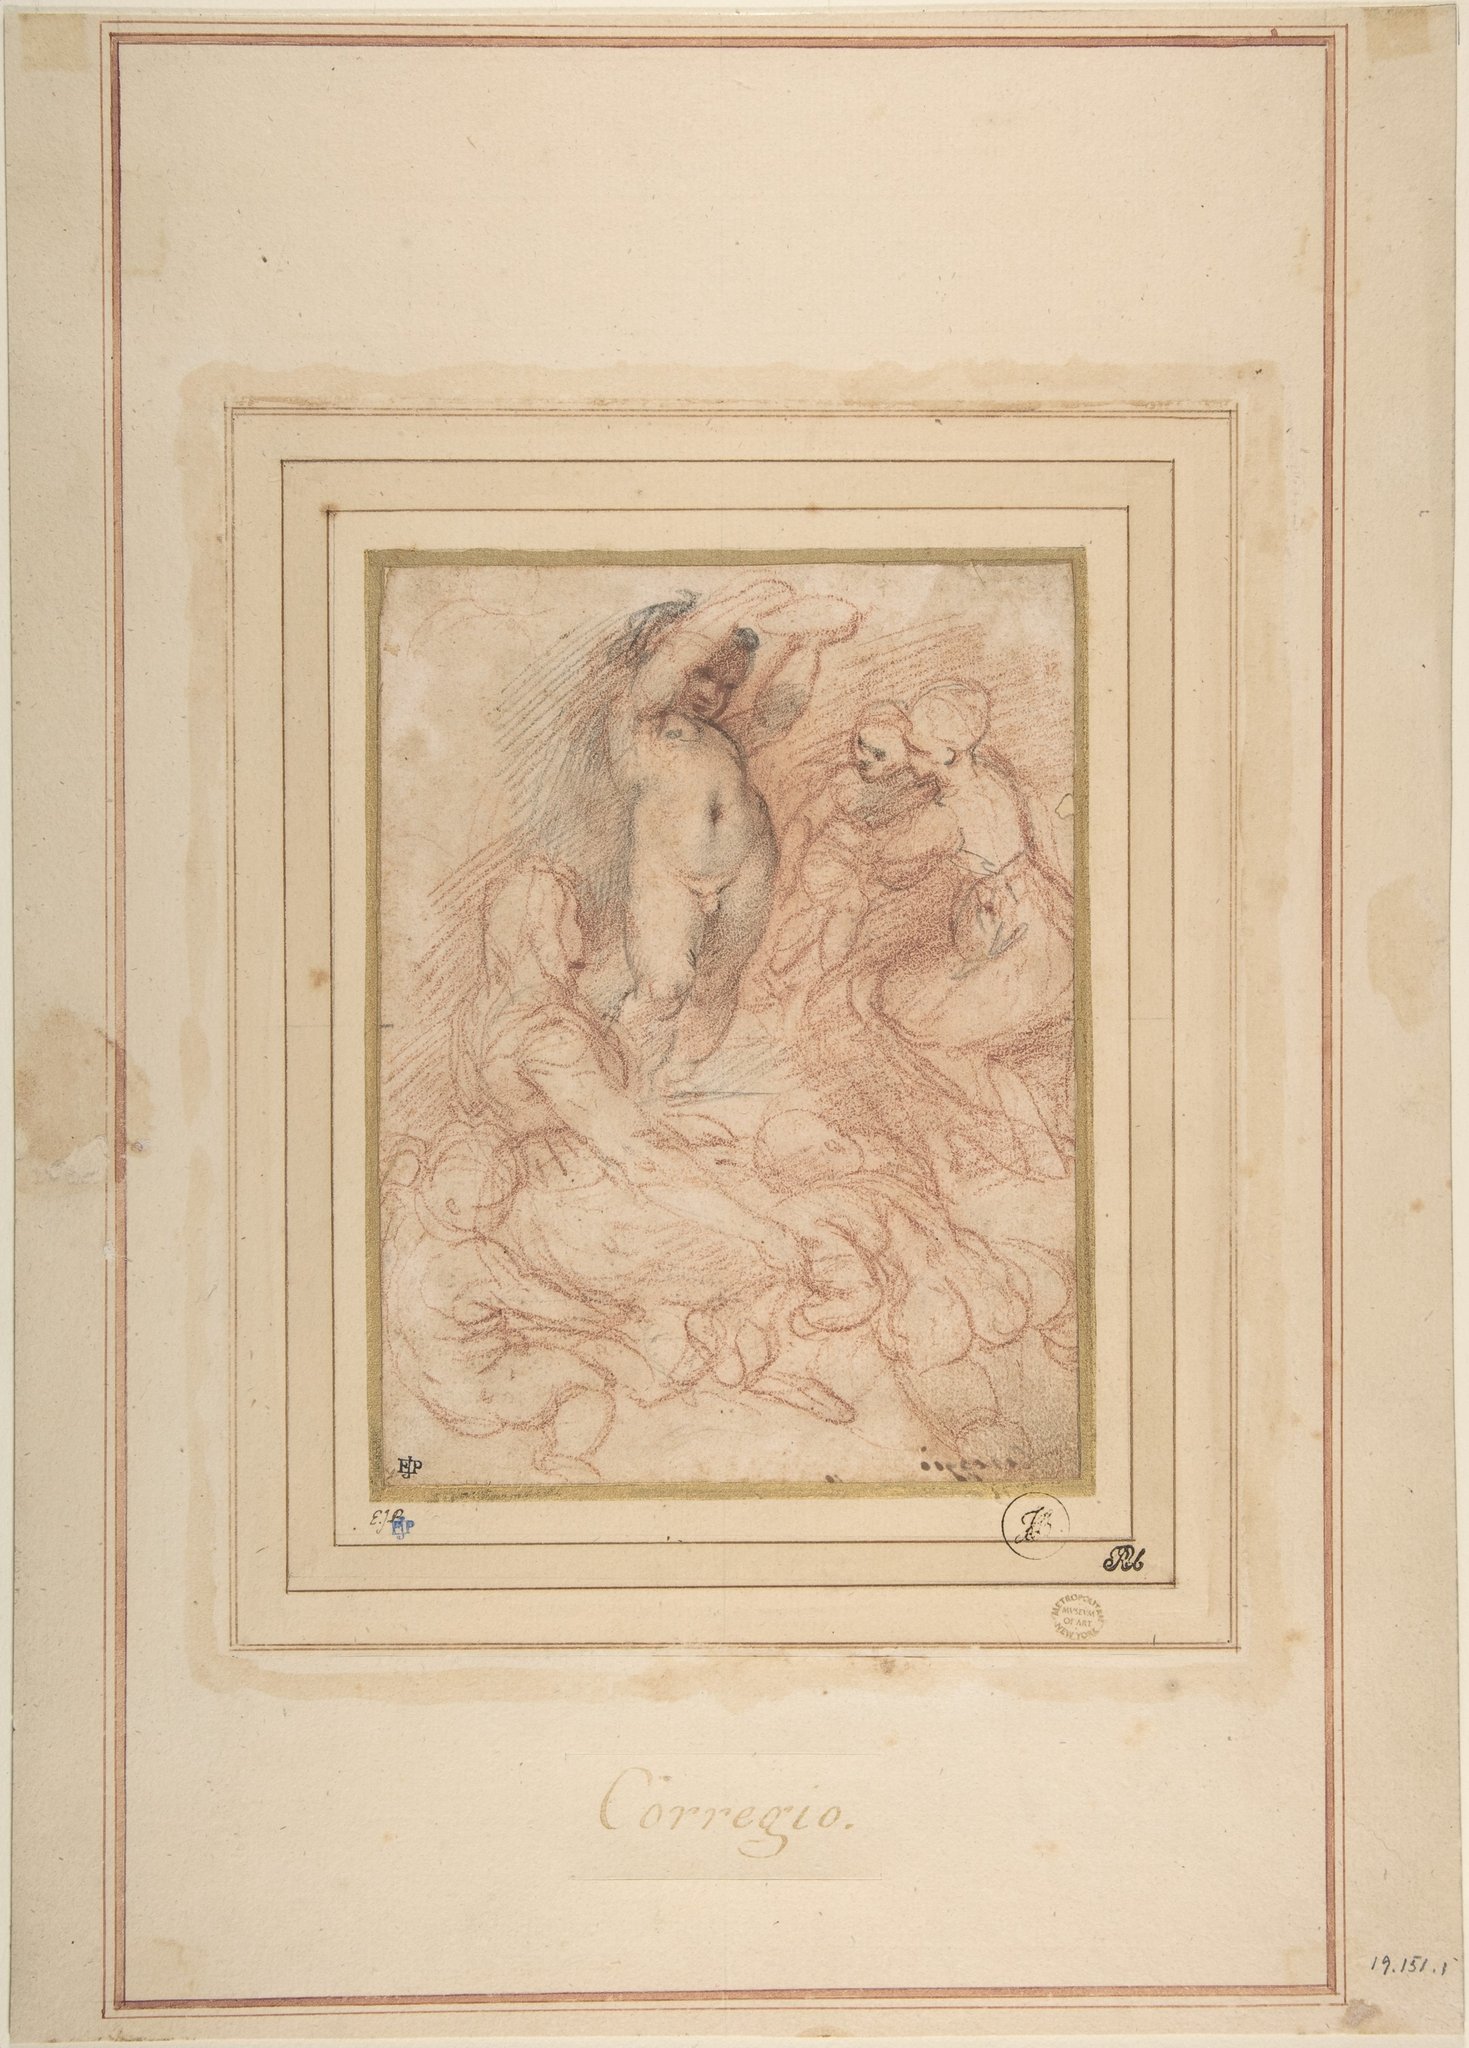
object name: drawing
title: Standing Nude Child Surrounded by Women and Children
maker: correggio (antonio allegri)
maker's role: artist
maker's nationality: italian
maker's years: 1514-1534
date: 1489-1534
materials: chalk, paper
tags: children,women